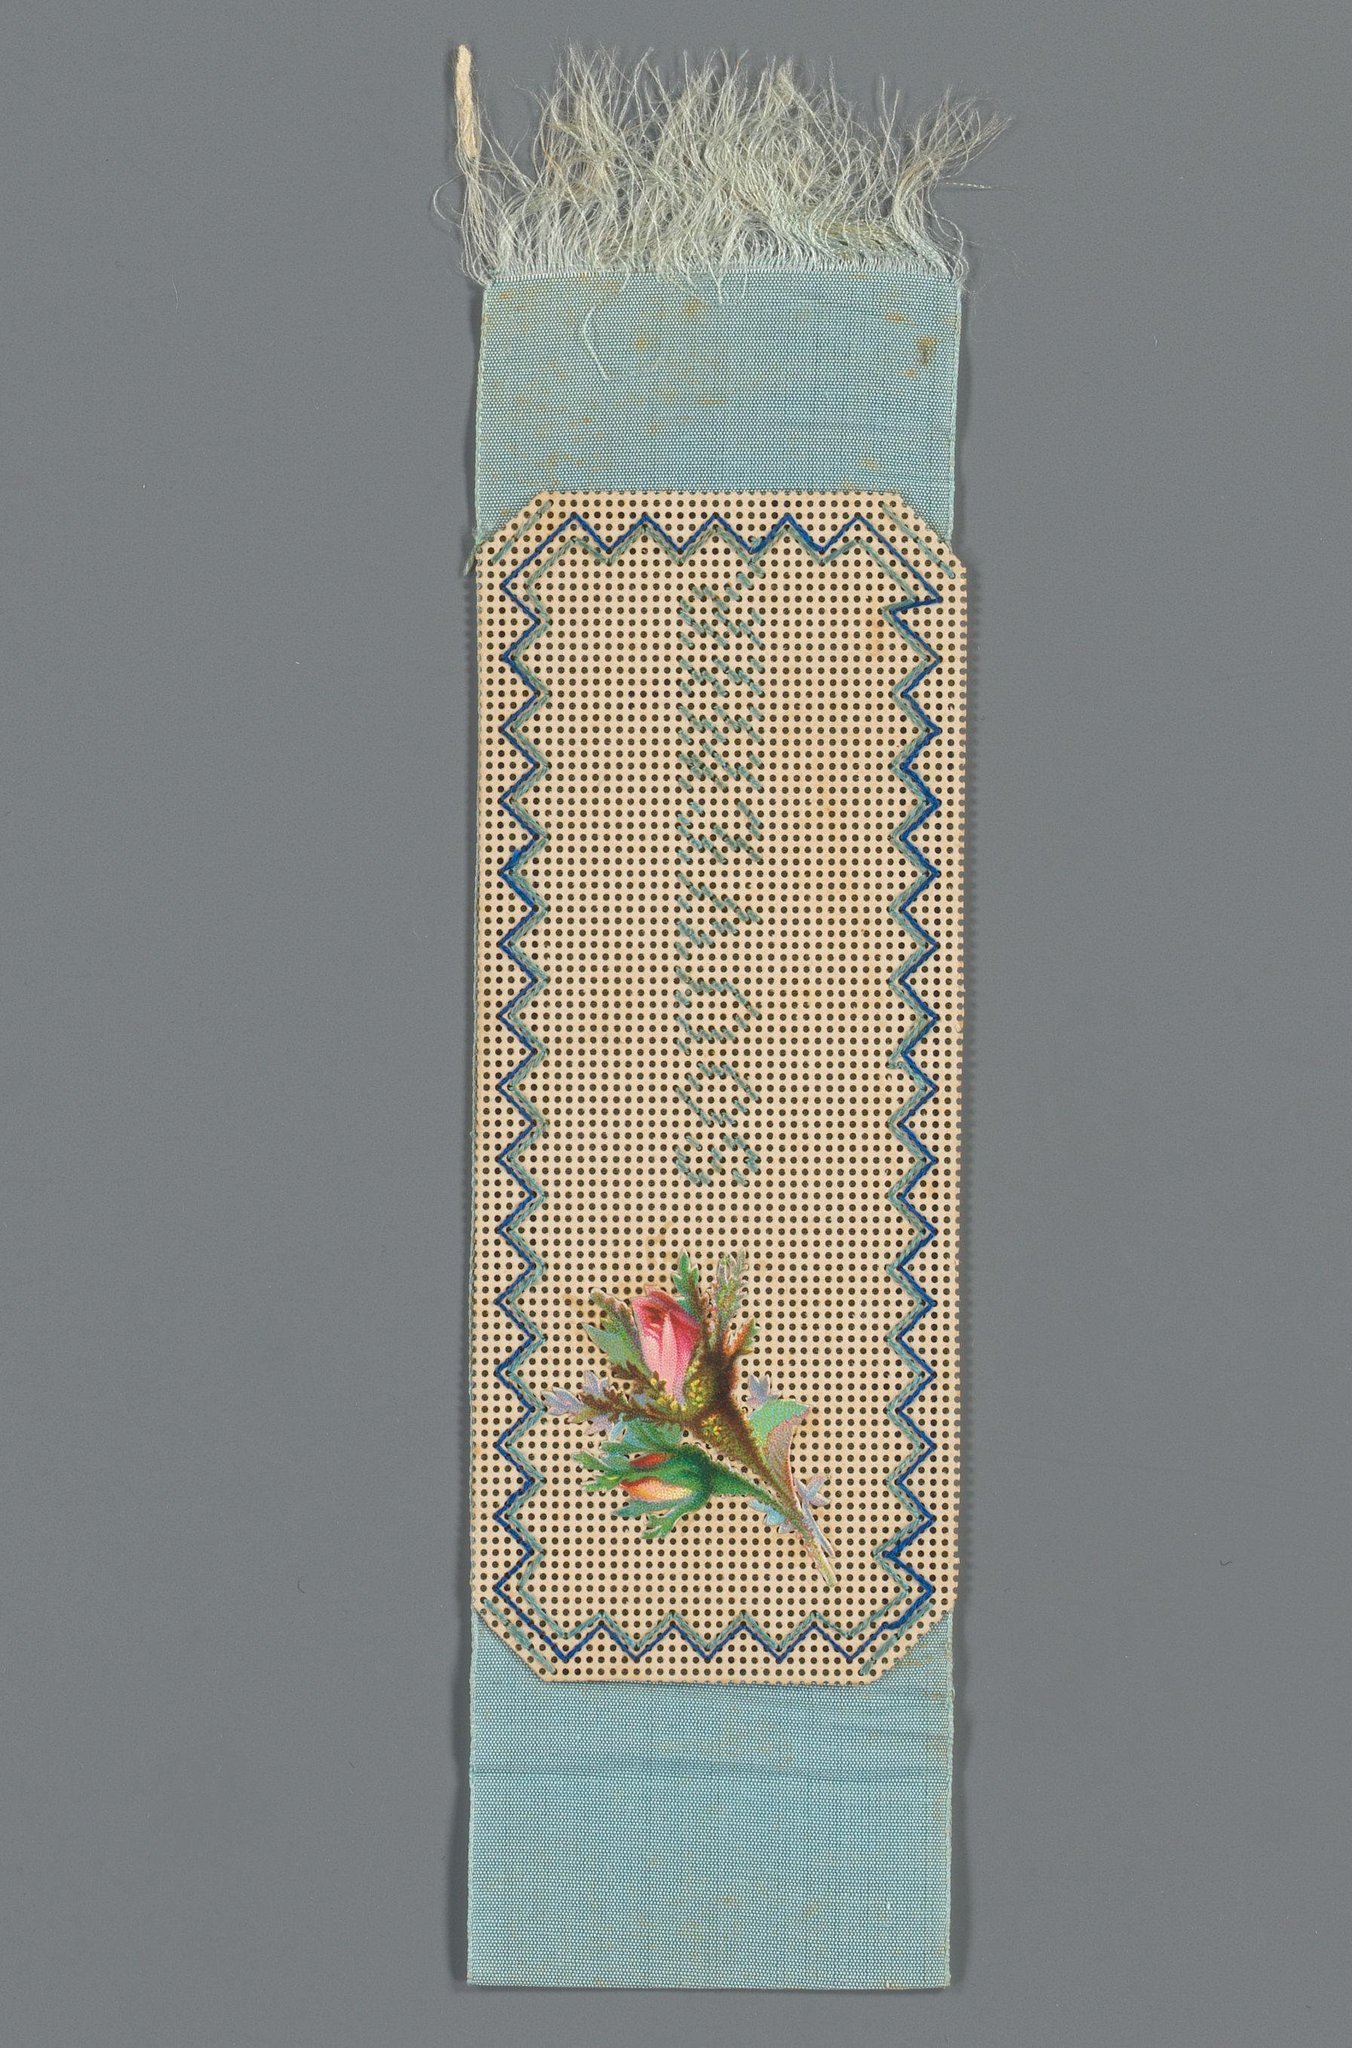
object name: bookmark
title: Boekenlegger met borduurwerk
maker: Anonymous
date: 1880-1980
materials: cardboard, paper, silk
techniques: embroidered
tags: book-marker, (other forms of) needlework, e.g.: crocheting, knitting, embroidering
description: Boekenlegger met borduurwerk 'Souvenir' op karton met gestanste gaatjes, met poesieplaatje van rozen geplakt op strook blauwe zijde.